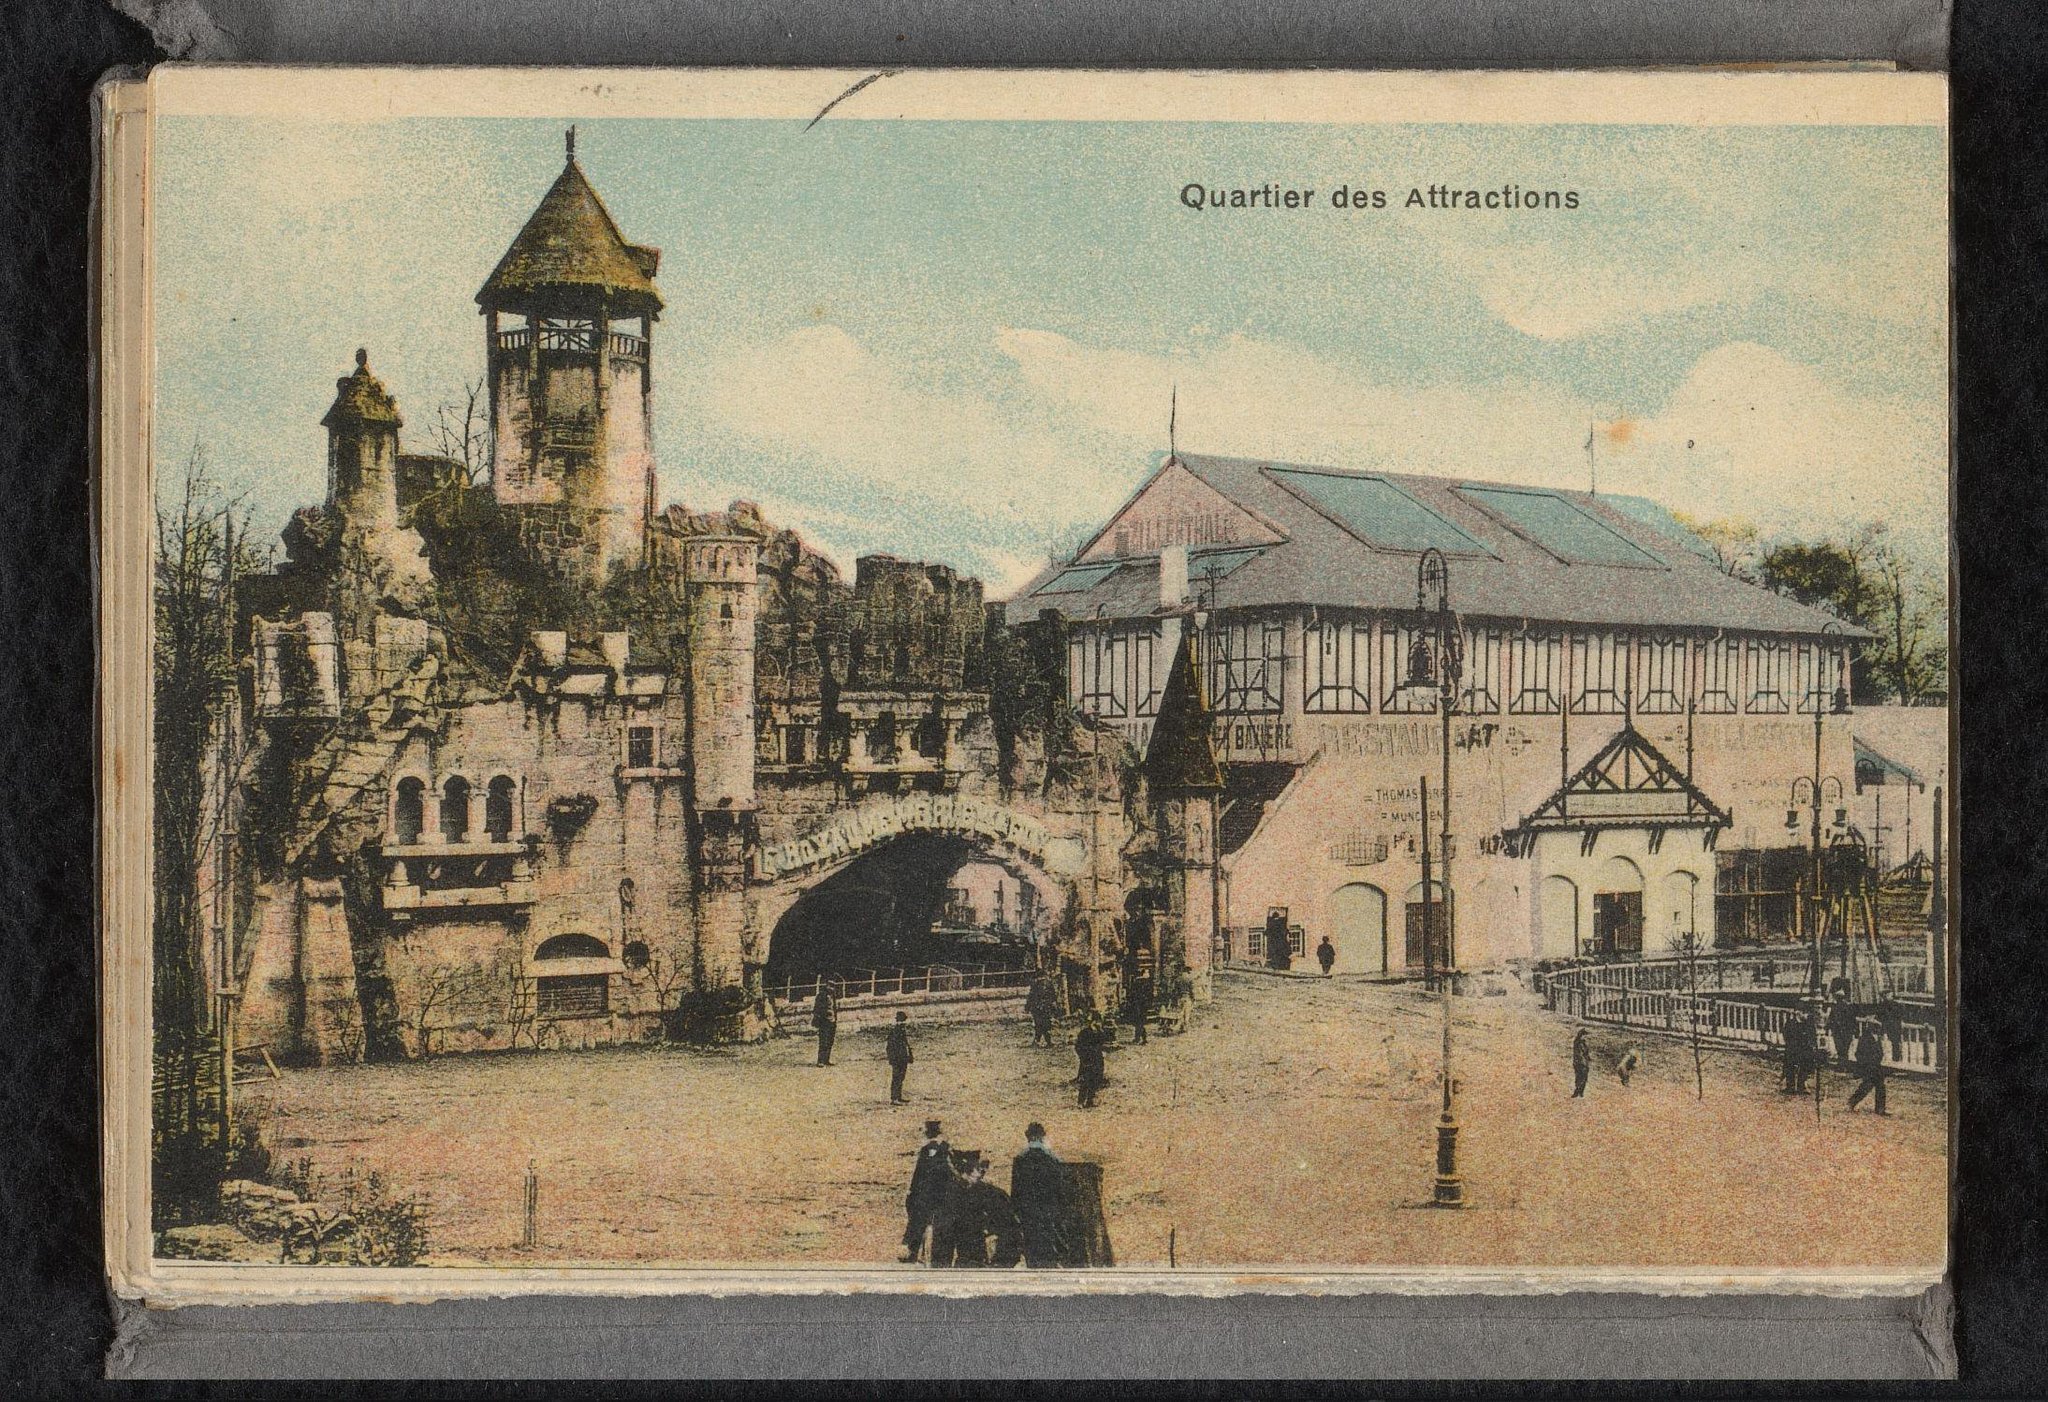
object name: ansichtkaart, prentbriefkaart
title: Quartier des Attractions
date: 1910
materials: cardboard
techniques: photograph, lithograph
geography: brussels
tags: world fair, world exhibition, city-view, and landscape with man-made constructions (+ city(-scape) with figures, staffage), brussels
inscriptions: date